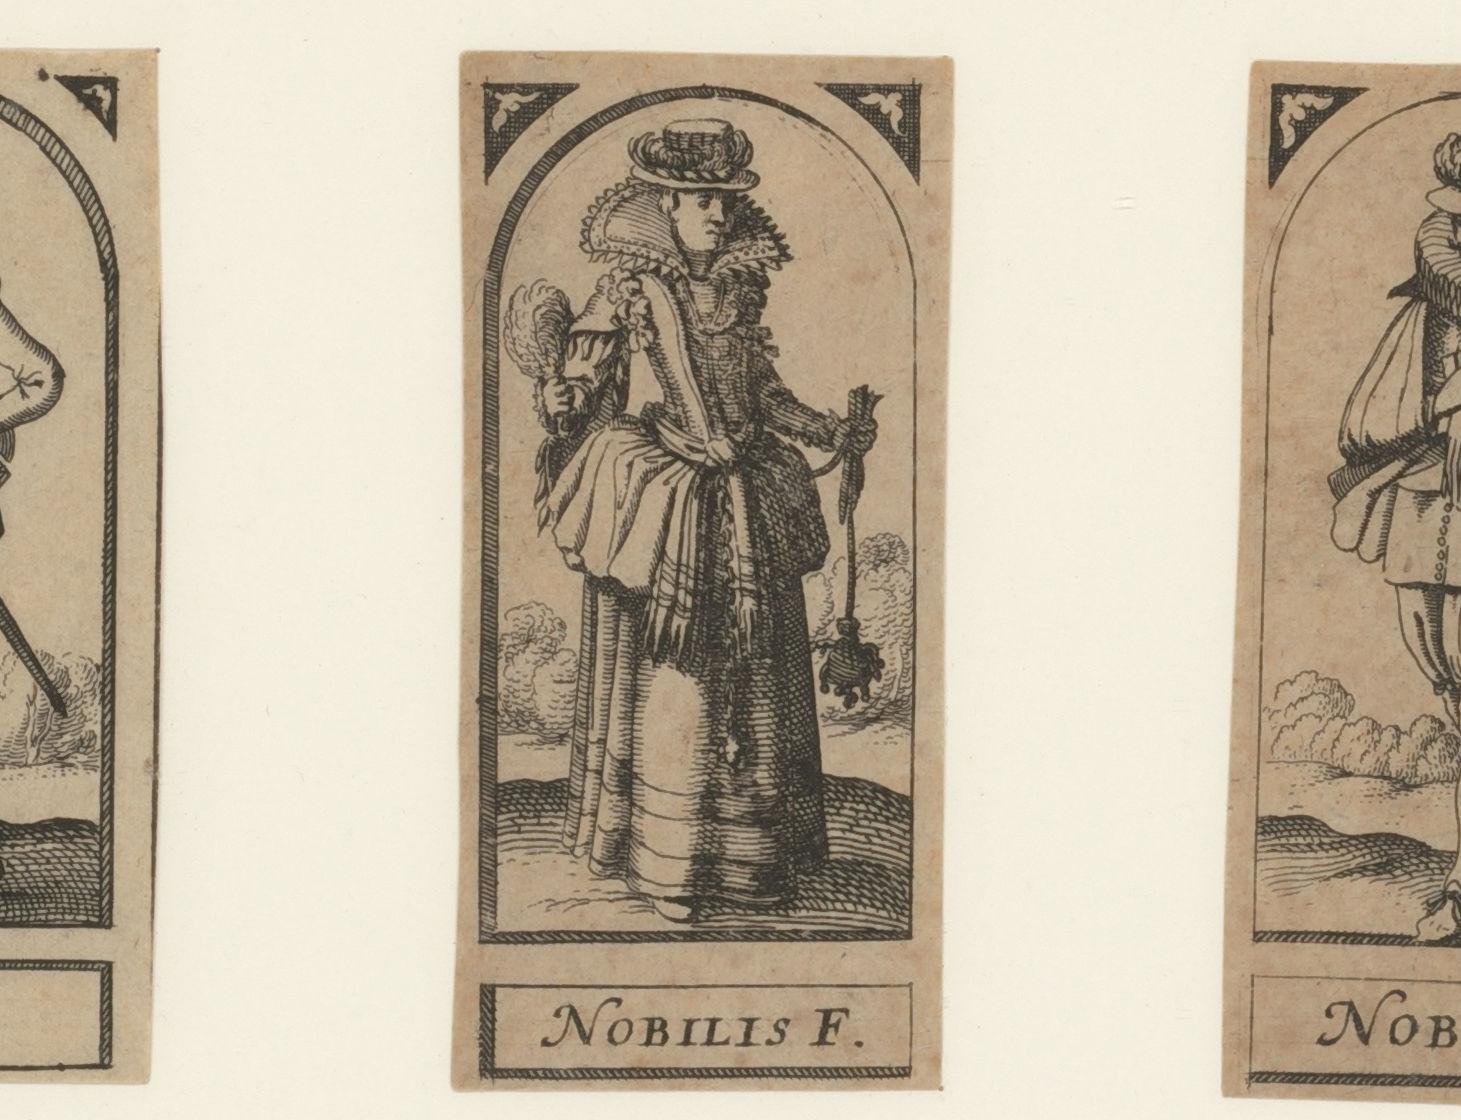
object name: print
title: Noblis F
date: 1620-1649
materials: paper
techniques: etching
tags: folk costume, regional costume, nobility and patriciate; chivalry, knighthood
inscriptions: stamp, collector's mark: Lugt 1641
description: Onderwerpsrubrieken binnen de Atlas Zeden en Gewoonten: Zeden en Gewoonten in Engeren Zin, De Kleeding, Kleederdrachten (tijdvakken), De Spaansche tijd. (1550 – 1600).